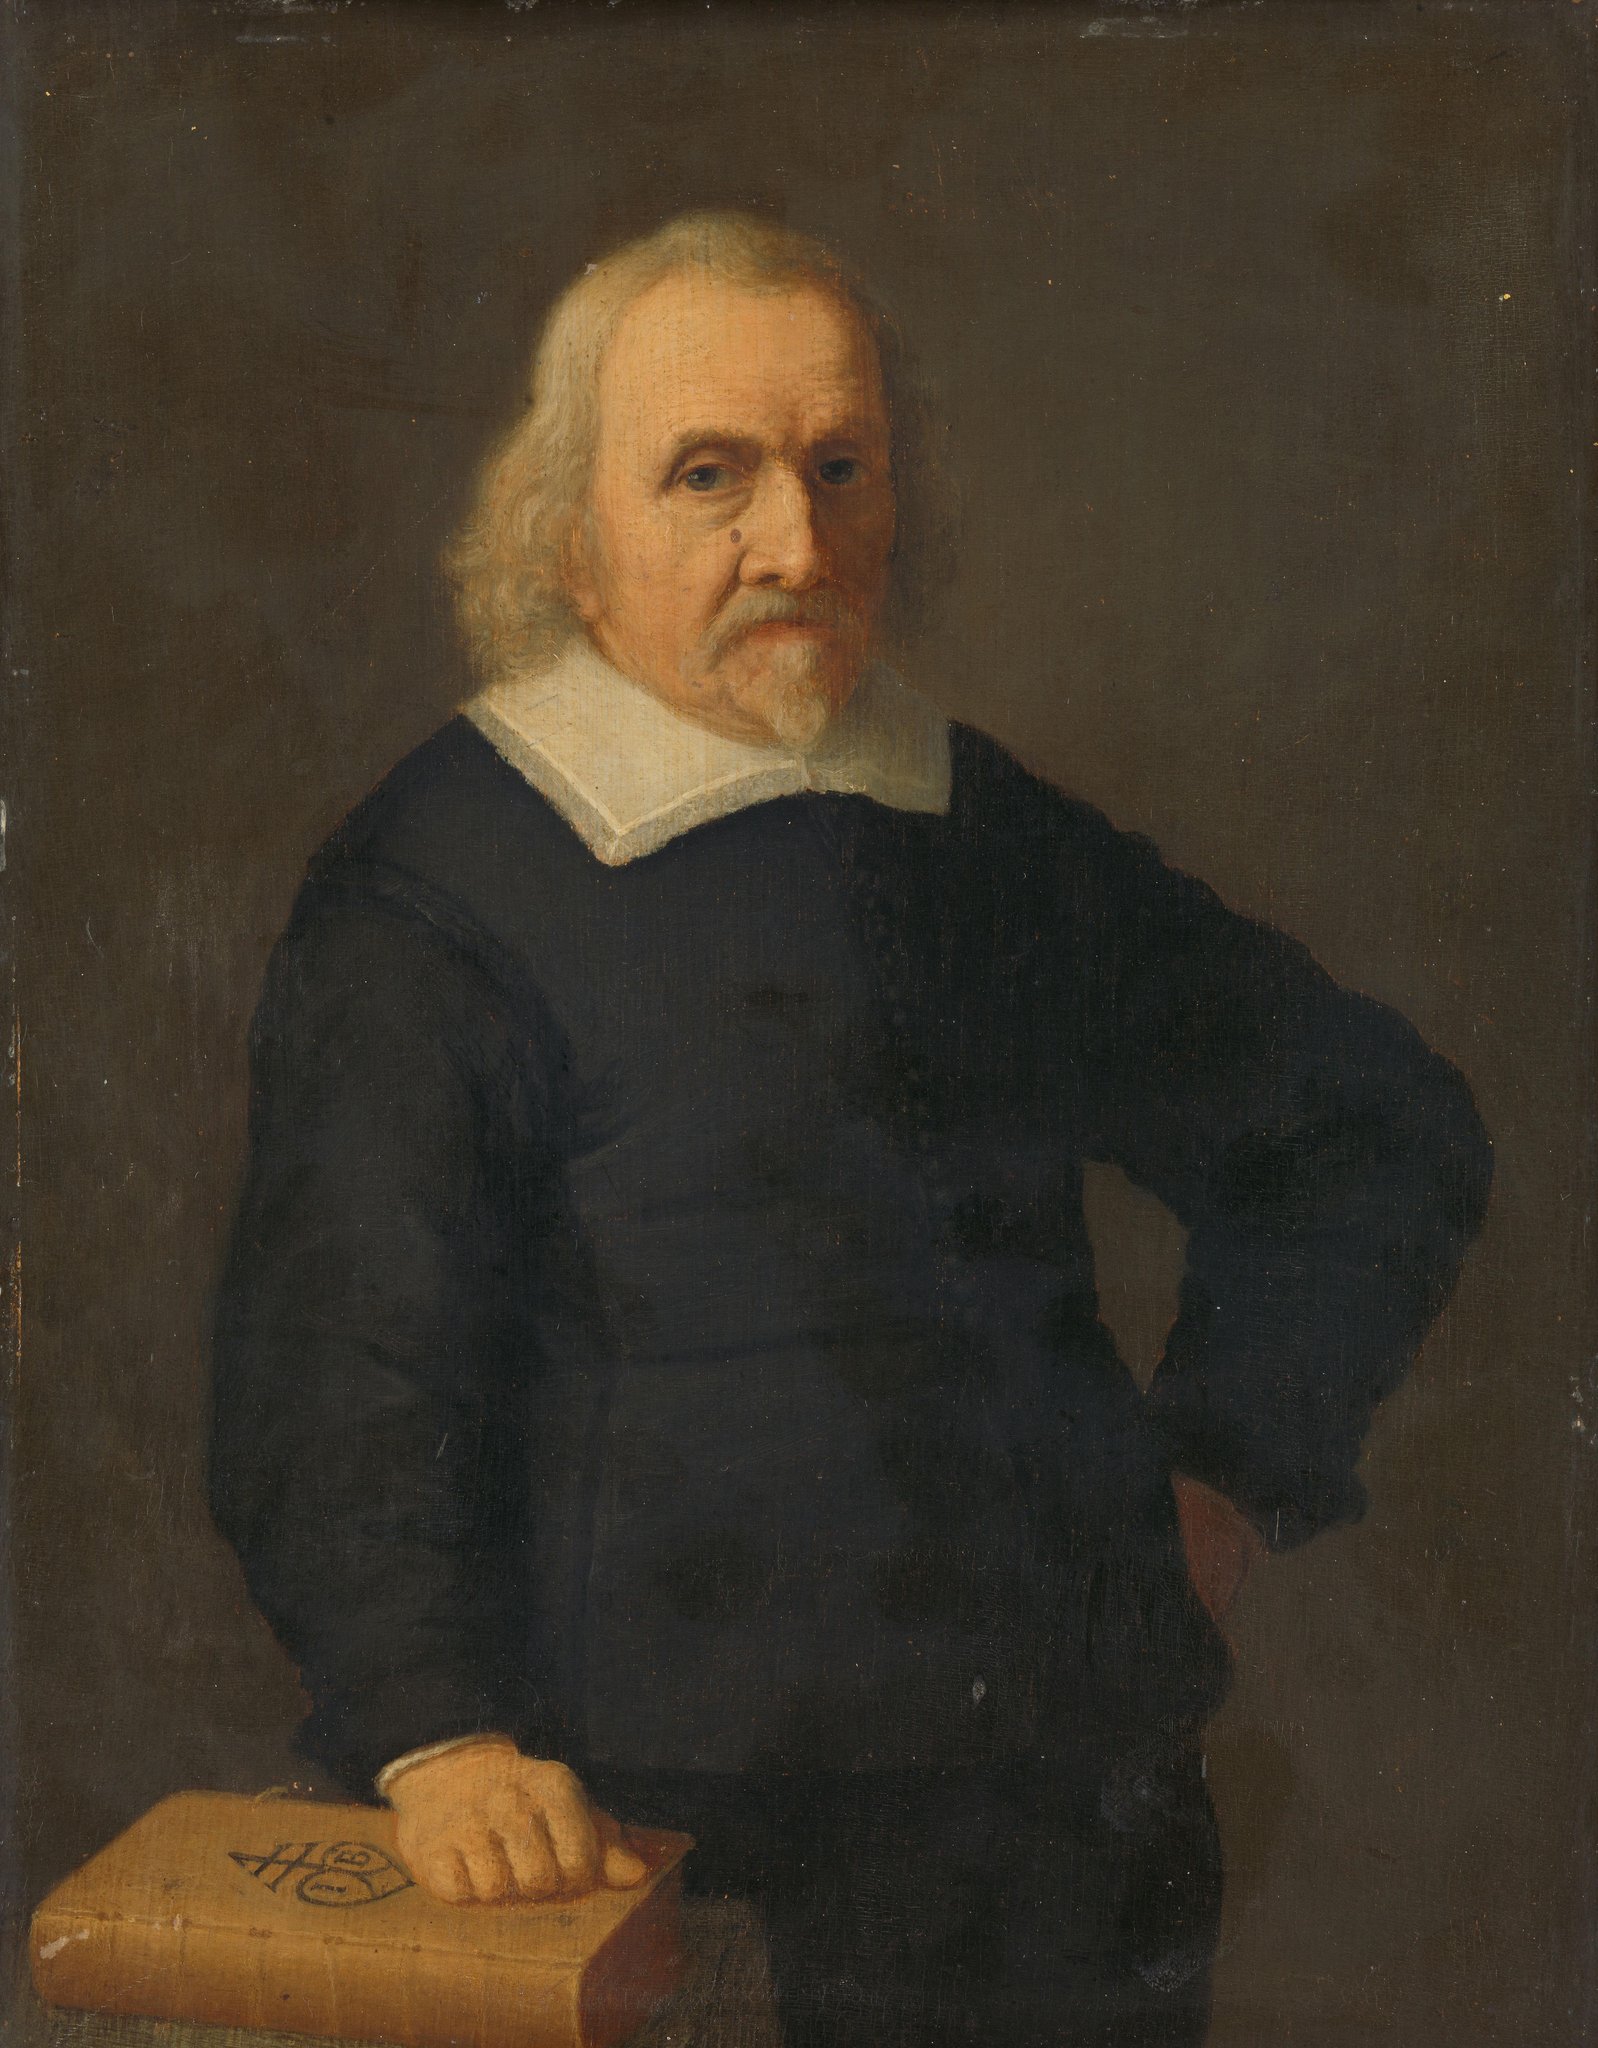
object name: painting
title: Portrait of a Man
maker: Anonymous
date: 1650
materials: oil, panel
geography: netherlands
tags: anonymous historical person portrayed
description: Portret van een man. Ten halven lijve, staande naar rechts, met de rechterhand geleund op een boek op een tafel, de linkerhand in de zij.